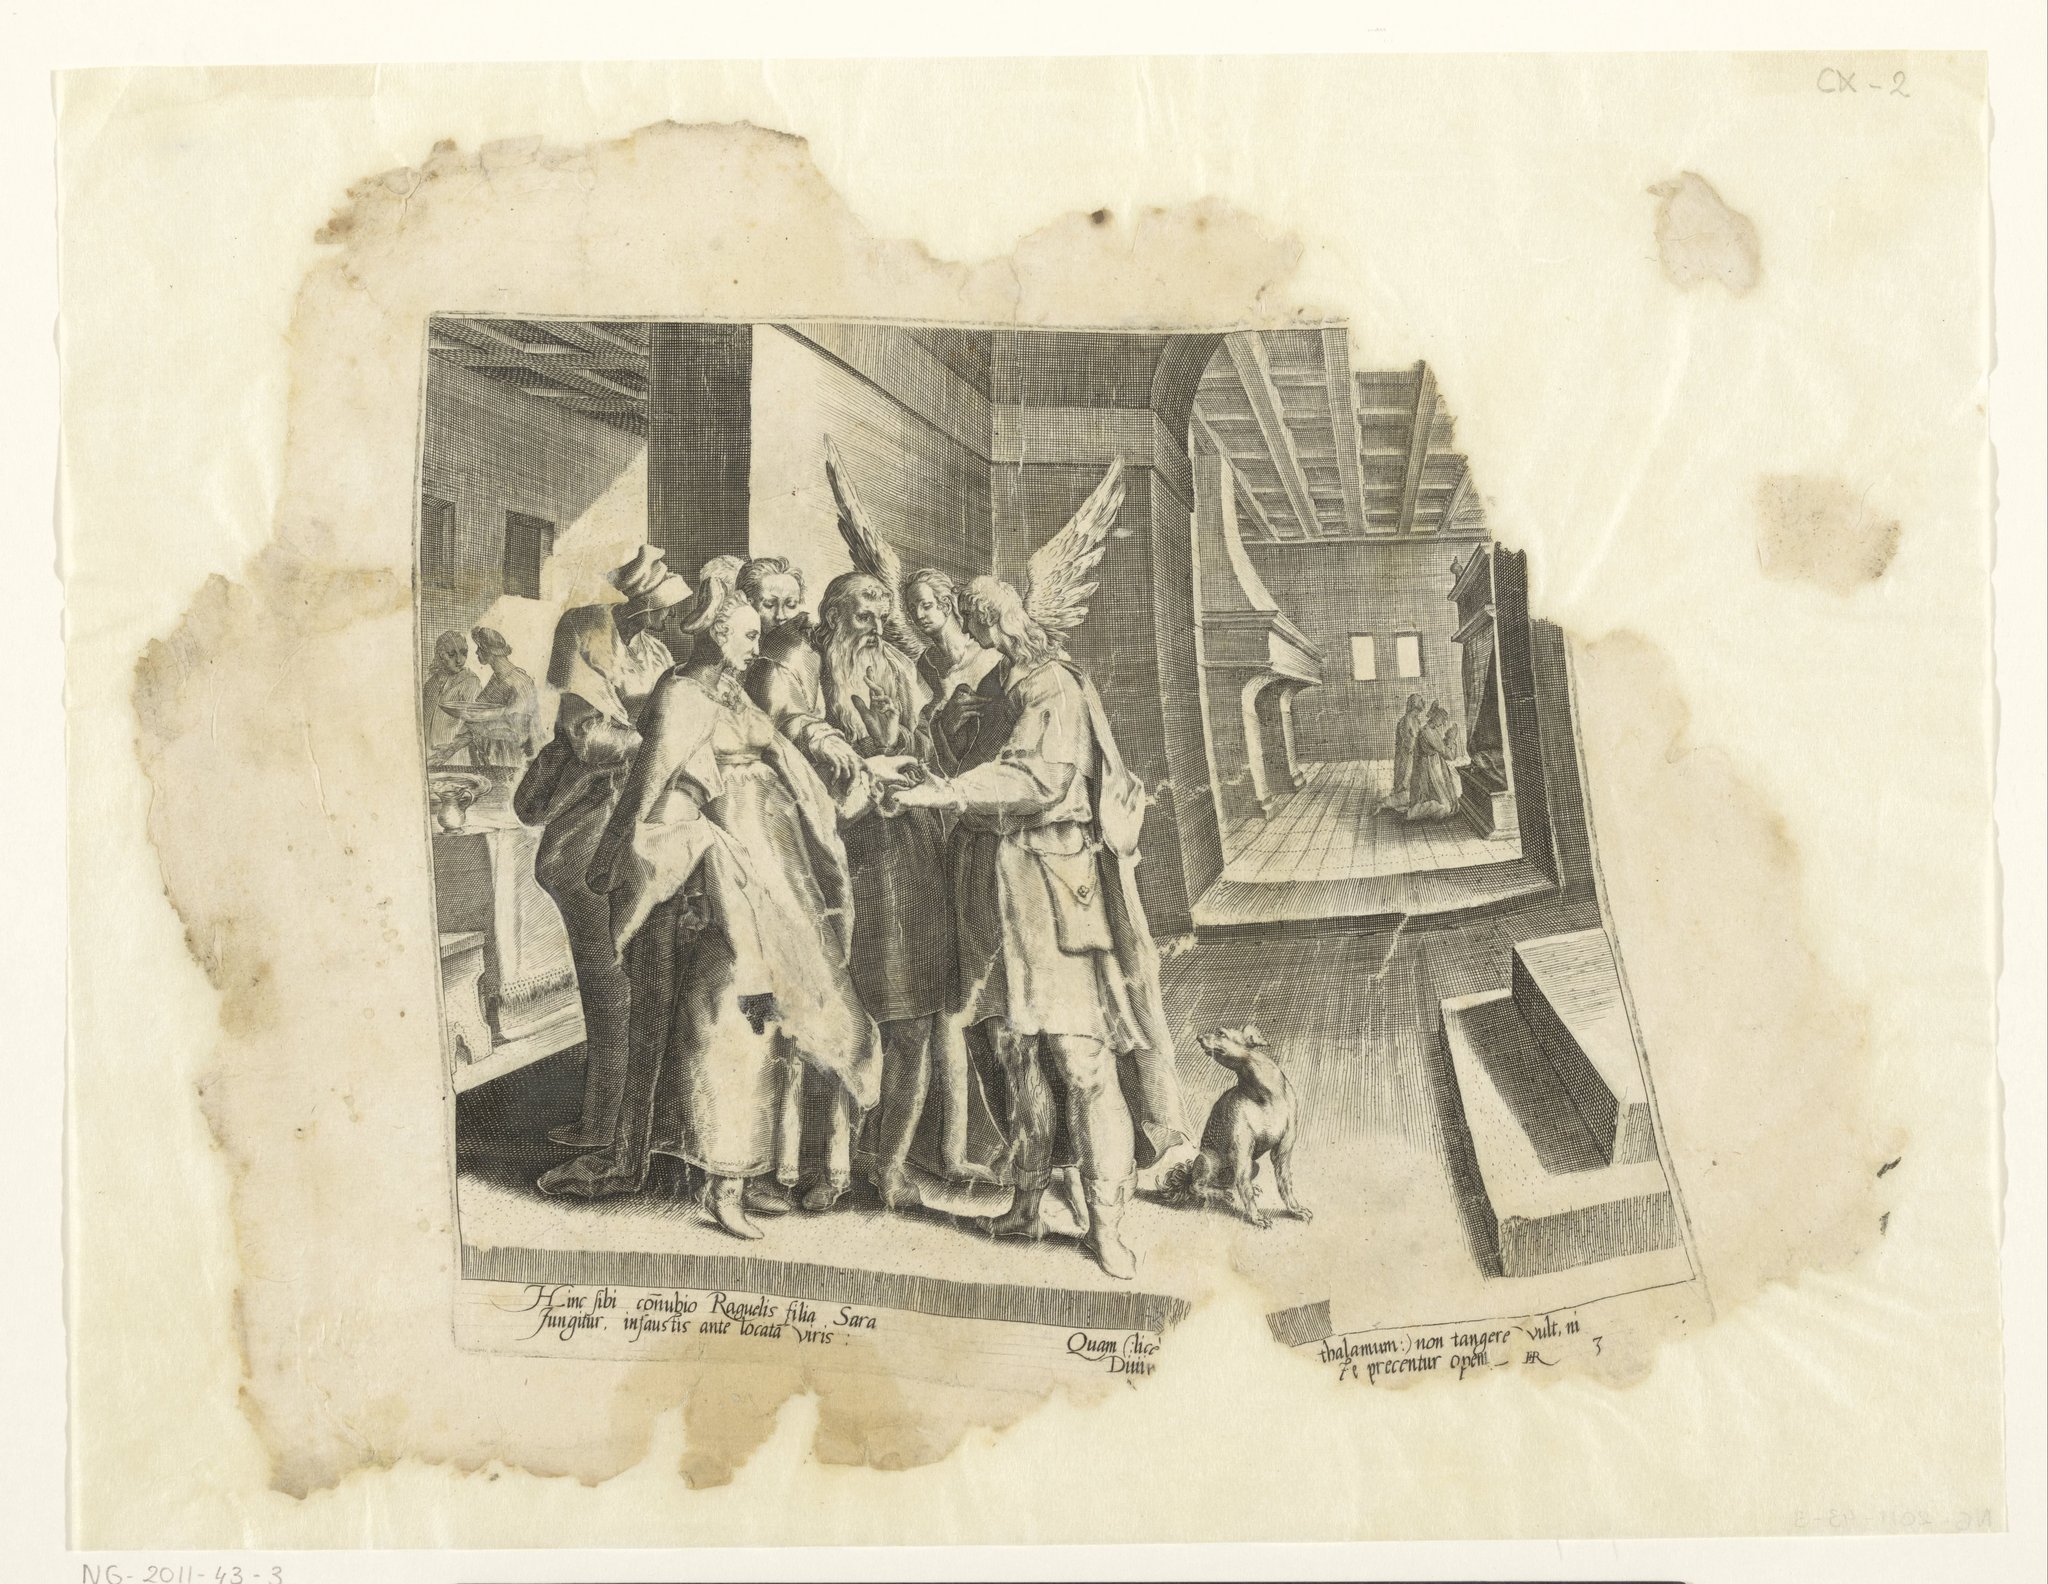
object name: print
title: Huwelijk van Tobias en Sara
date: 1580-1596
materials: paper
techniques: engraving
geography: amsterdam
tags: tobias and sarah praying, raguel gives sarah to tobias as his wife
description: De prenten in de Nova Zembla collectie zijn tijdens een expeditie van Willem Barendsz en Jacob van Heemskerk in 1596-1597 noodgedwongen in het winterkamp, het ‘Behouden Huis’, op het eiland achtergelaten. De prenten waren in één of meerdere stapels als handelswaar meegenomen vanuit Amsterdam. Bijna drie eeuwen later, in 1871, keerde de Noor Elling Carlsen terug naar Nova Zembla en vond daar de restanten van het ‘Behouden Huis, inclusief een groot deel van de inventaris. Een deel van de prenten, in de vorm van aaneengekoekte kluiten, werd toen ook teruggevonden. De papierkluiten waren soms op meerdere plekken gebroken. Tussen 1975-1979 zijn de prenten van elkaar gescheiden. Dit leverde in totaal ca. 1000 fragmenten van ca. 400 afdrukken van ca. 150 verschillende prenten op. Voor zover mogelijk zijn de fragmenten samengevoegd en zijn de prenten gereconstrueerd.